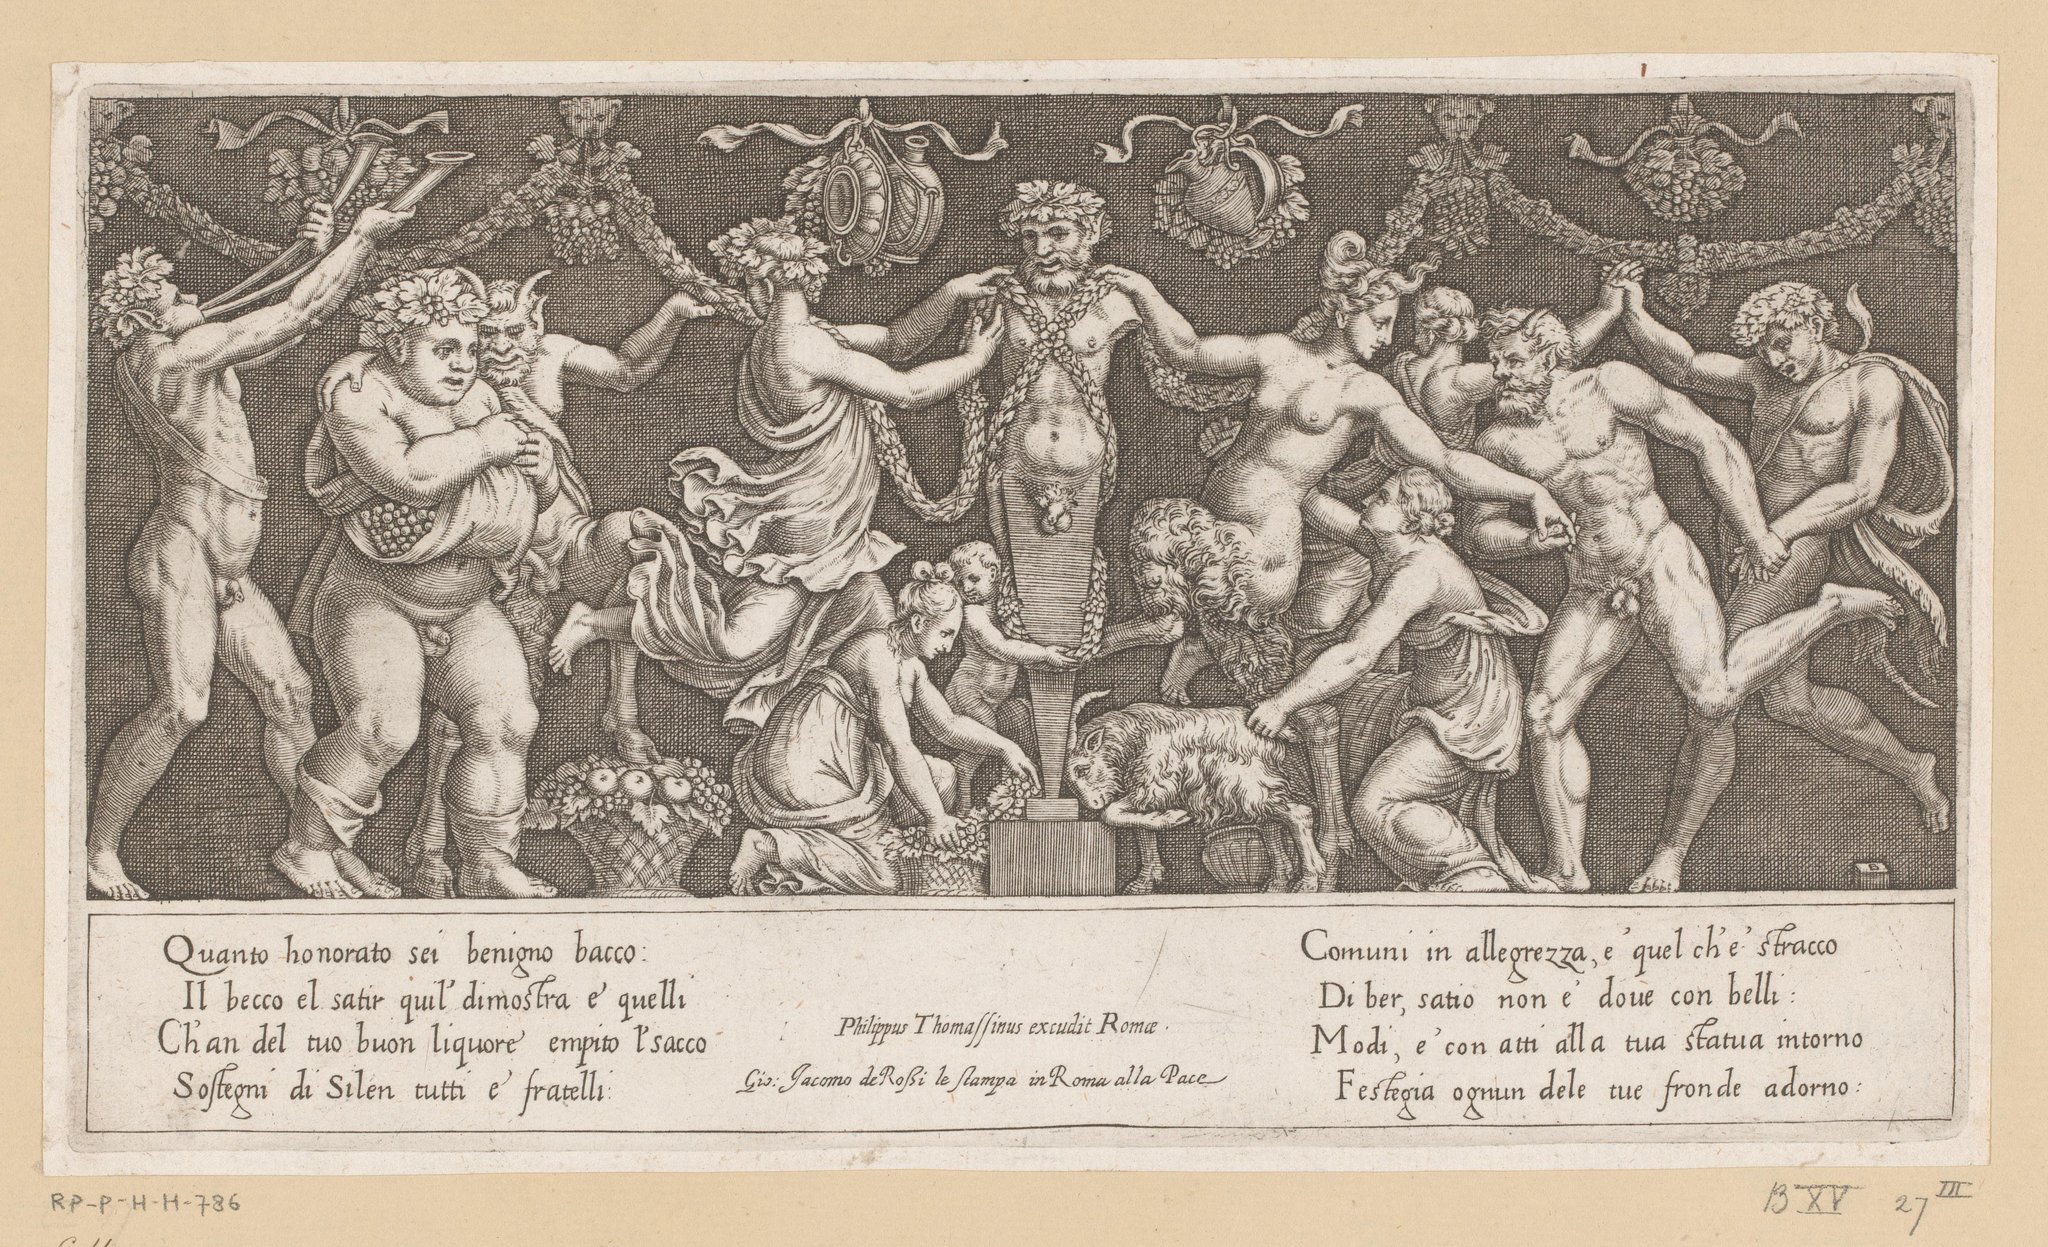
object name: print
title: Offer aan Priapus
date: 1530-1560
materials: paper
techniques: engraving, intaglio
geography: italy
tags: horn, trumpet, cornet, trombone, tuba, maenad(s), female bacchant(es), animal sacrifice ~ roman religion, male bacchant(es), priapus-herm, satyr(s) (in general)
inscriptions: collector's mark: ‘Hinloopen’, collector's mark: Lugt 10, collector's mark: Lugt 11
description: In het midden staat de vruchtbaarheidsgod Priapus in de vorm van een herme. Om hem heen dansen saters en maenaden. Links Bacchus en een figuur blazend op een dubbele hoorn. Onderaan de herme wordt een ram aan Priapus geofferd. Italiaanse tekst in twee kolommen in ondermarge.